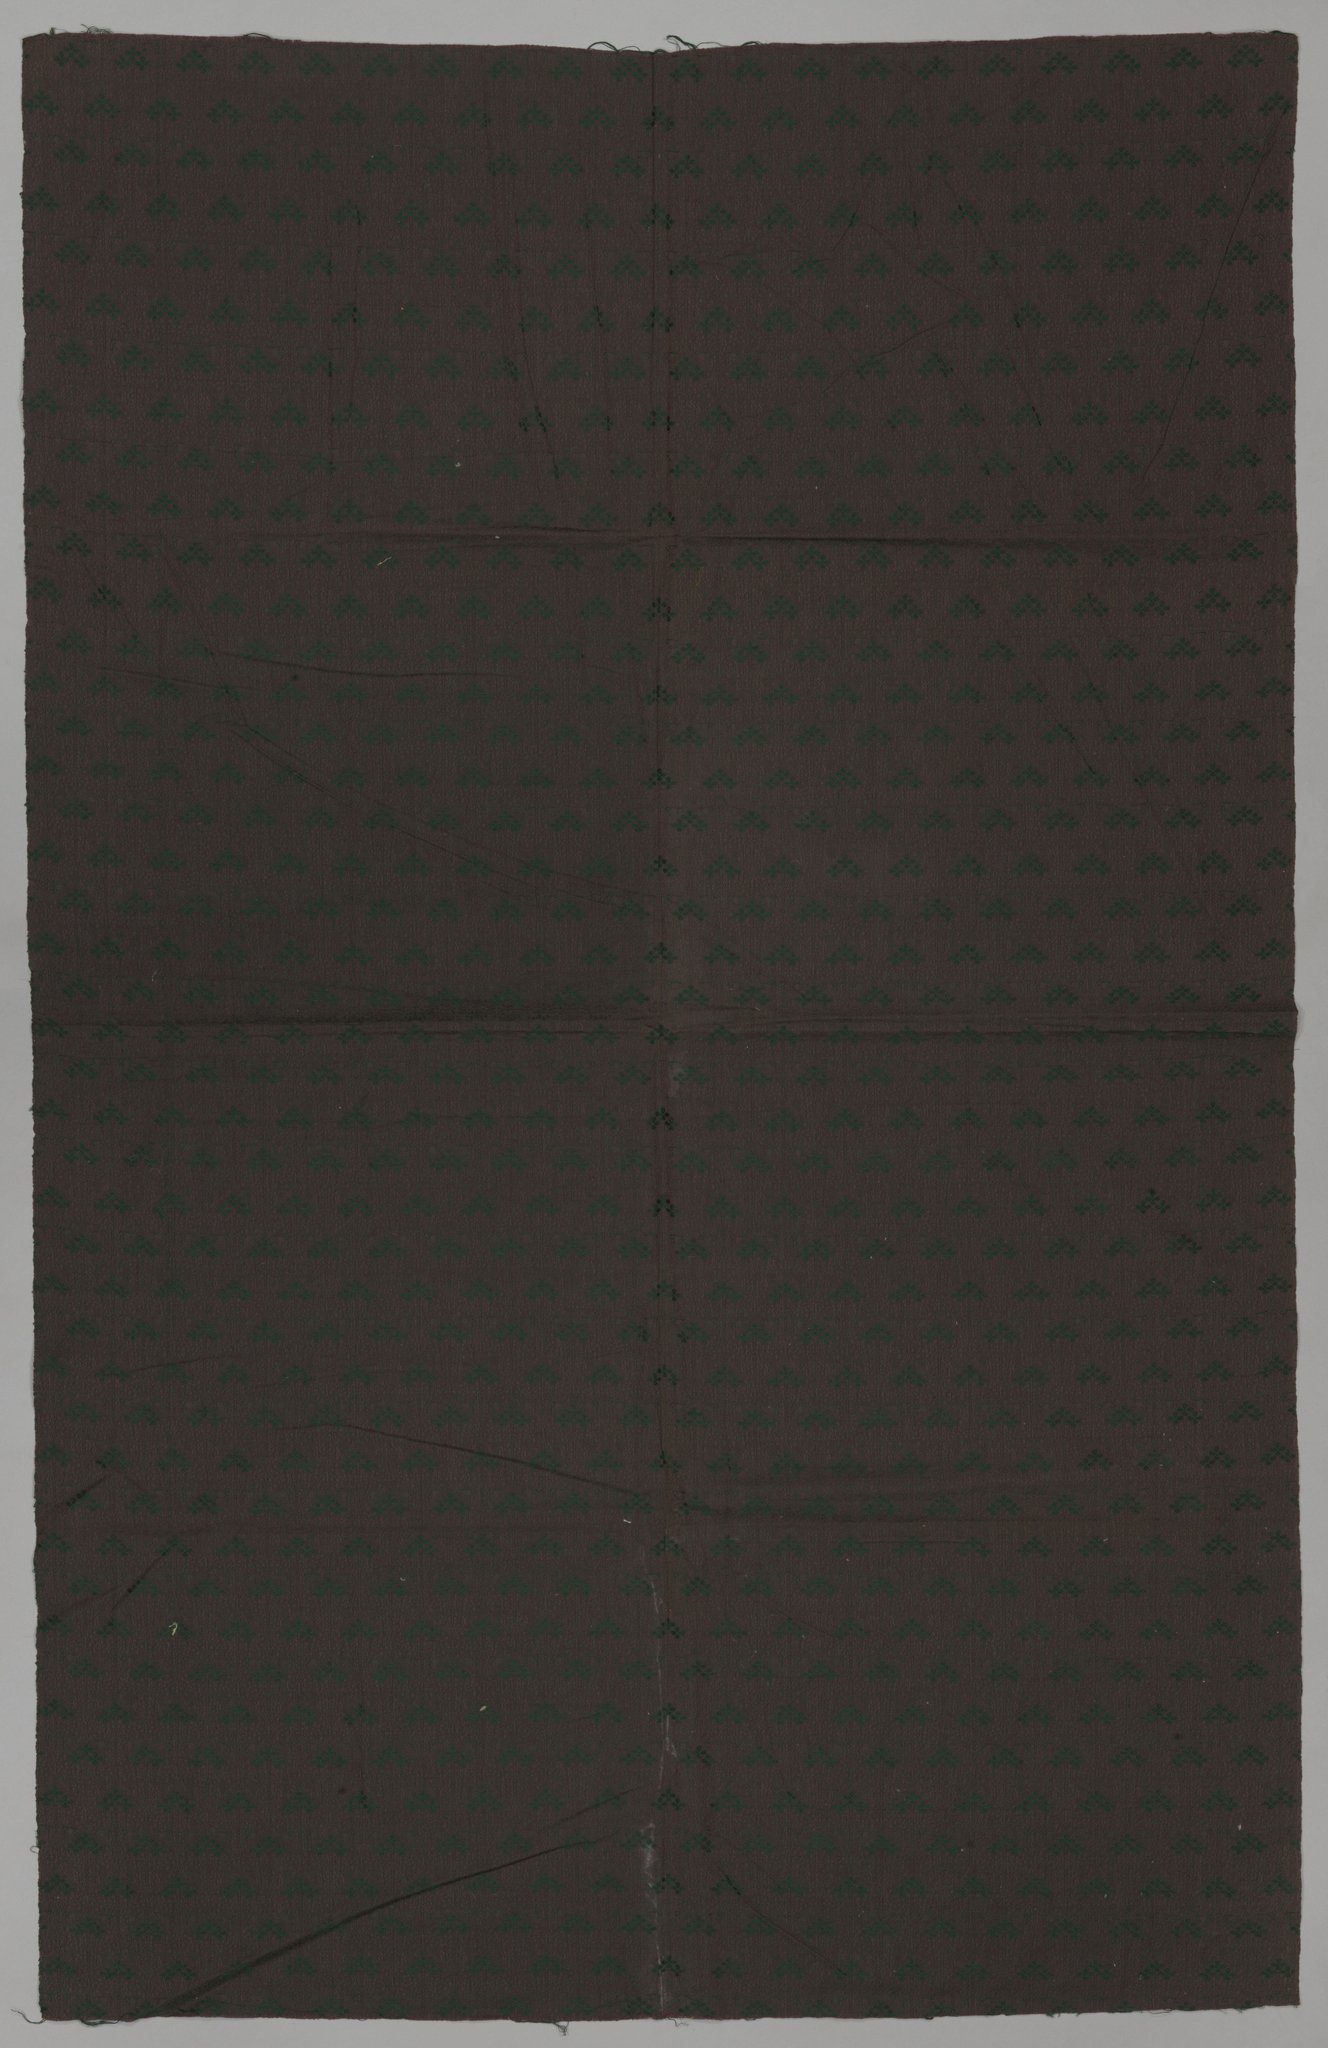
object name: upholstery fabric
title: Bespanningsstof, jacquardweefsel met patroon van spitsovalen, groene inslag op paarse ketting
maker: theo nieuwenhuis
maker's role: designer, draughtsman, print maker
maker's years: 1866-1951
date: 1920-1930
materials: wool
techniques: jacquard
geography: helmond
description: Bespanningsstof, jacquardweefsel met patroon van spitsovalen, groene inslag op paarse ketting.